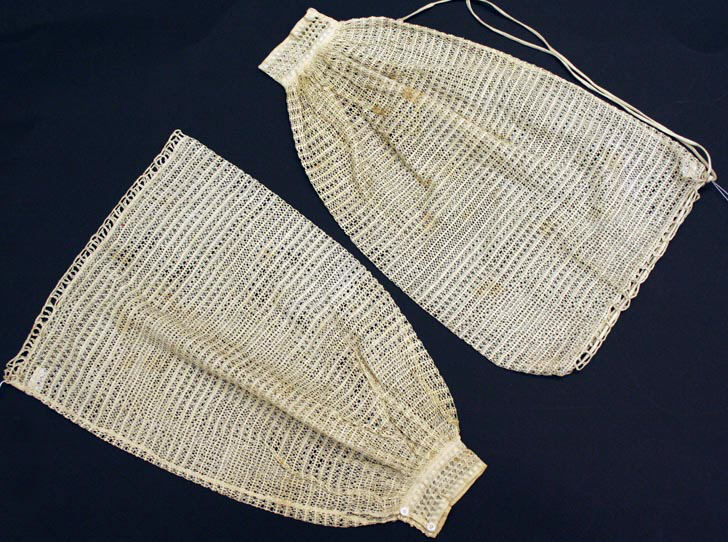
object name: undersleeves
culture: american or european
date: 1860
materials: cotton